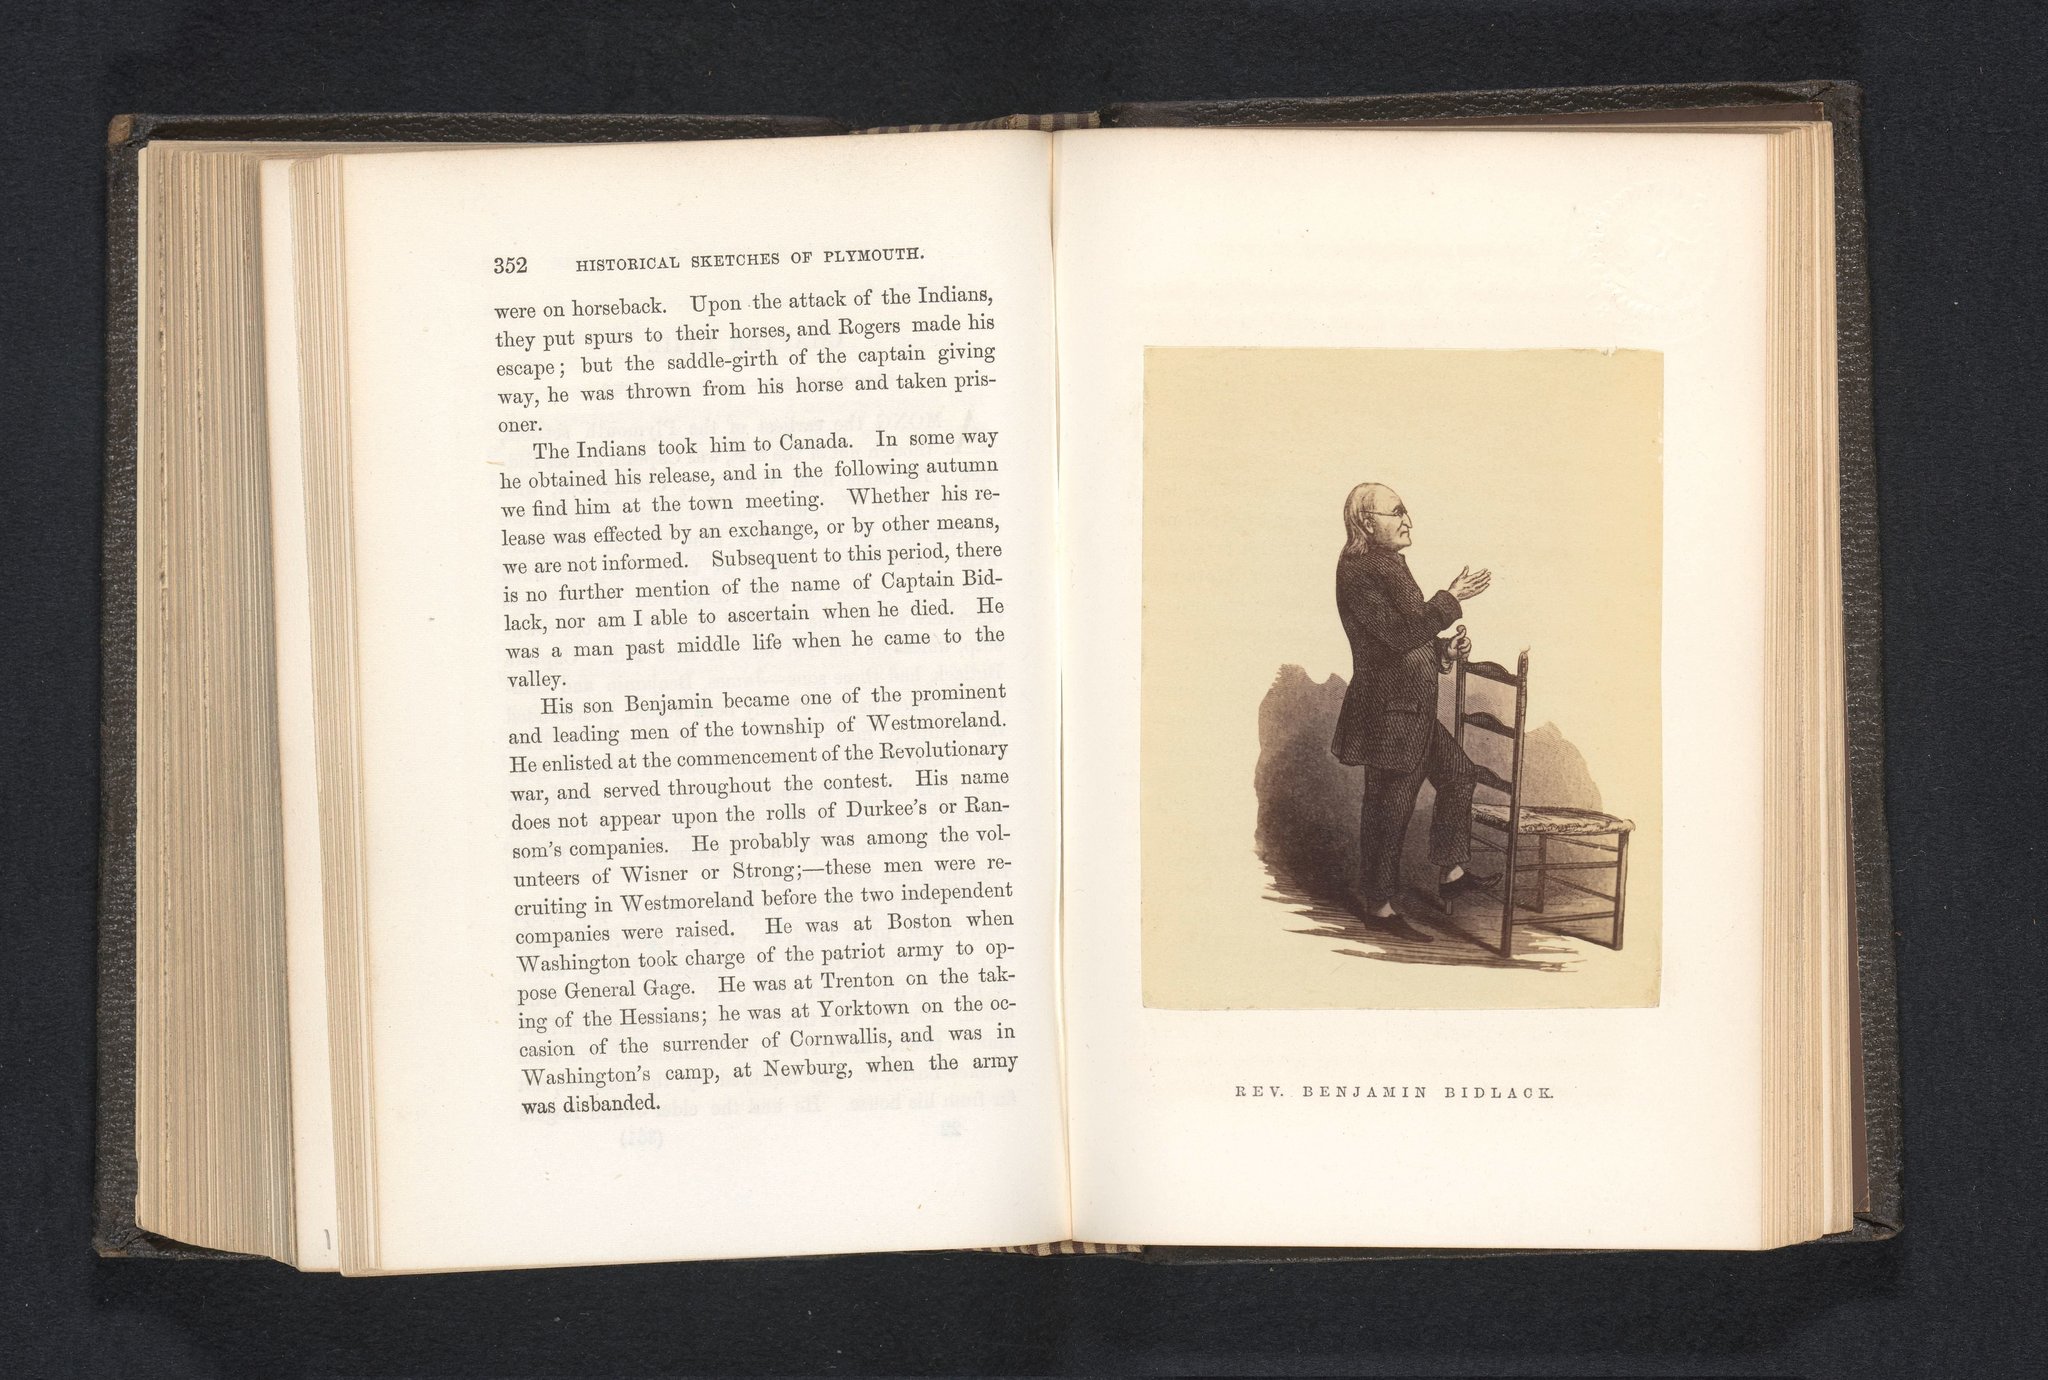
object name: page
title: Rev. Benjamin Bidlack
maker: william h. schurch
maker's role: fotograaf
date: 1868-1873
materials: photographic support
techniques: albumen print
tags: historical persons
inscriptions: collector's mark: ‘Essex Institute 1848’